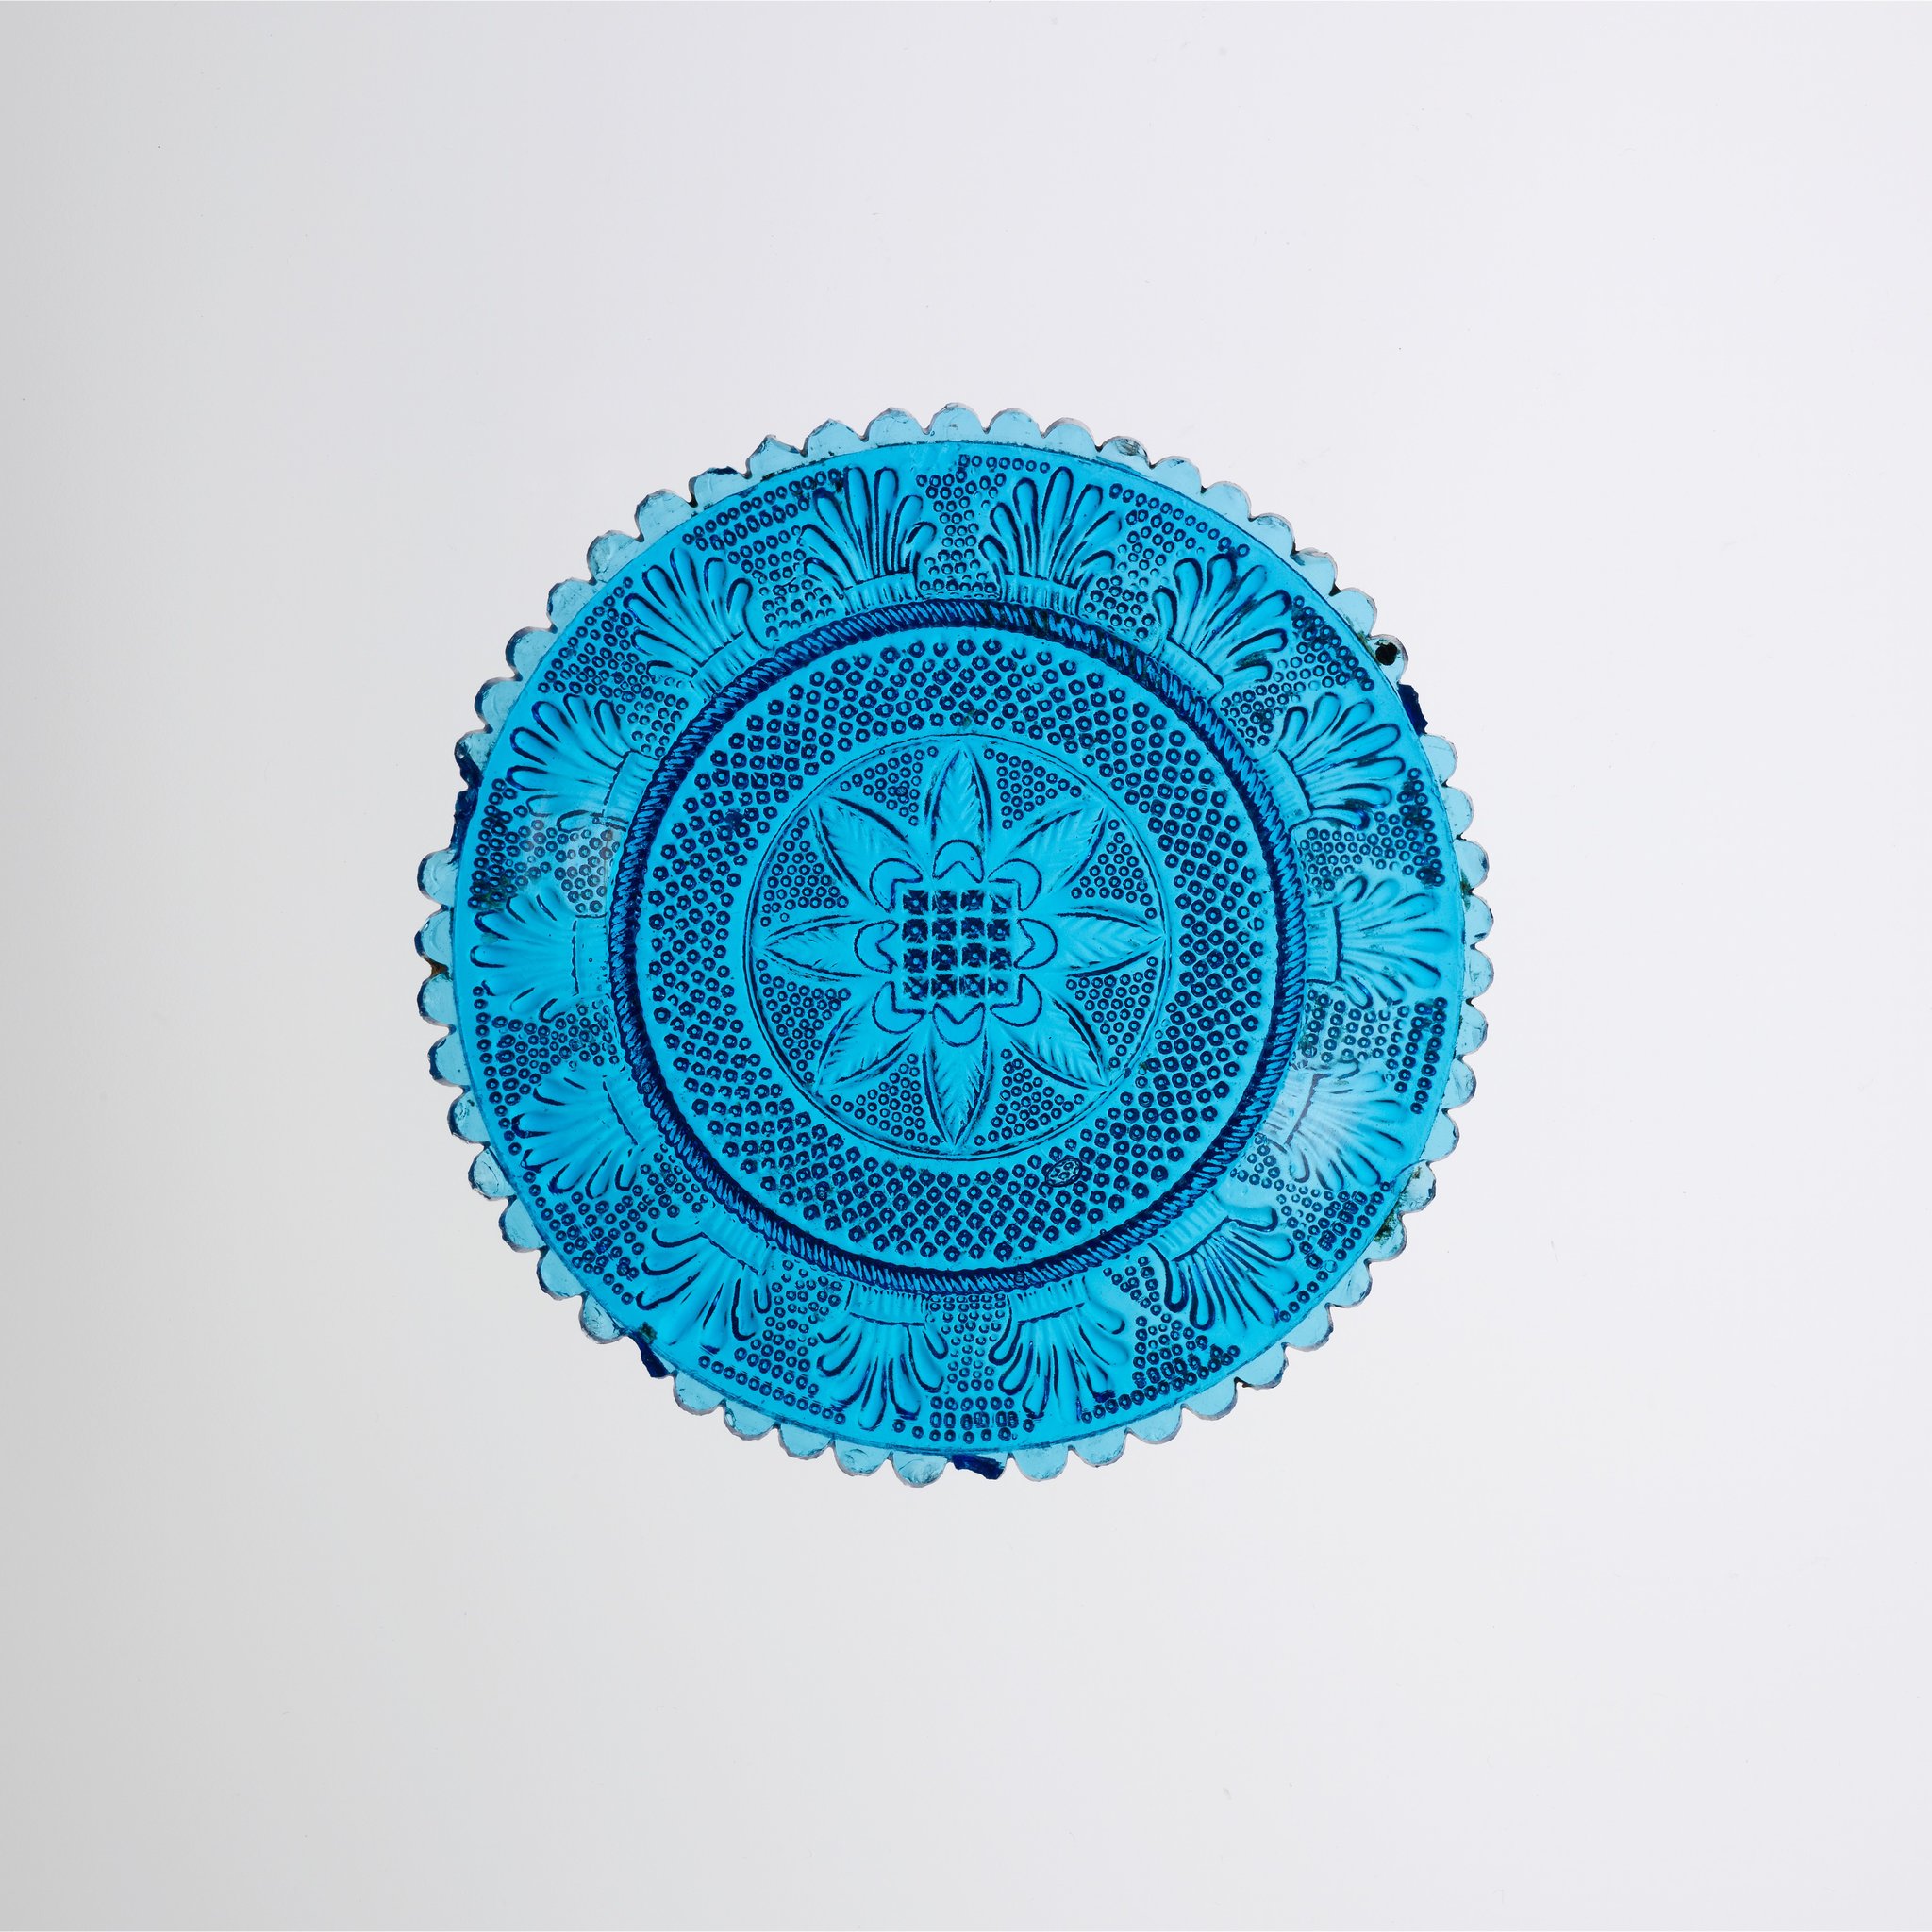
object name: cup plate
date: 1825-1860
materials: glass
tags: flowers